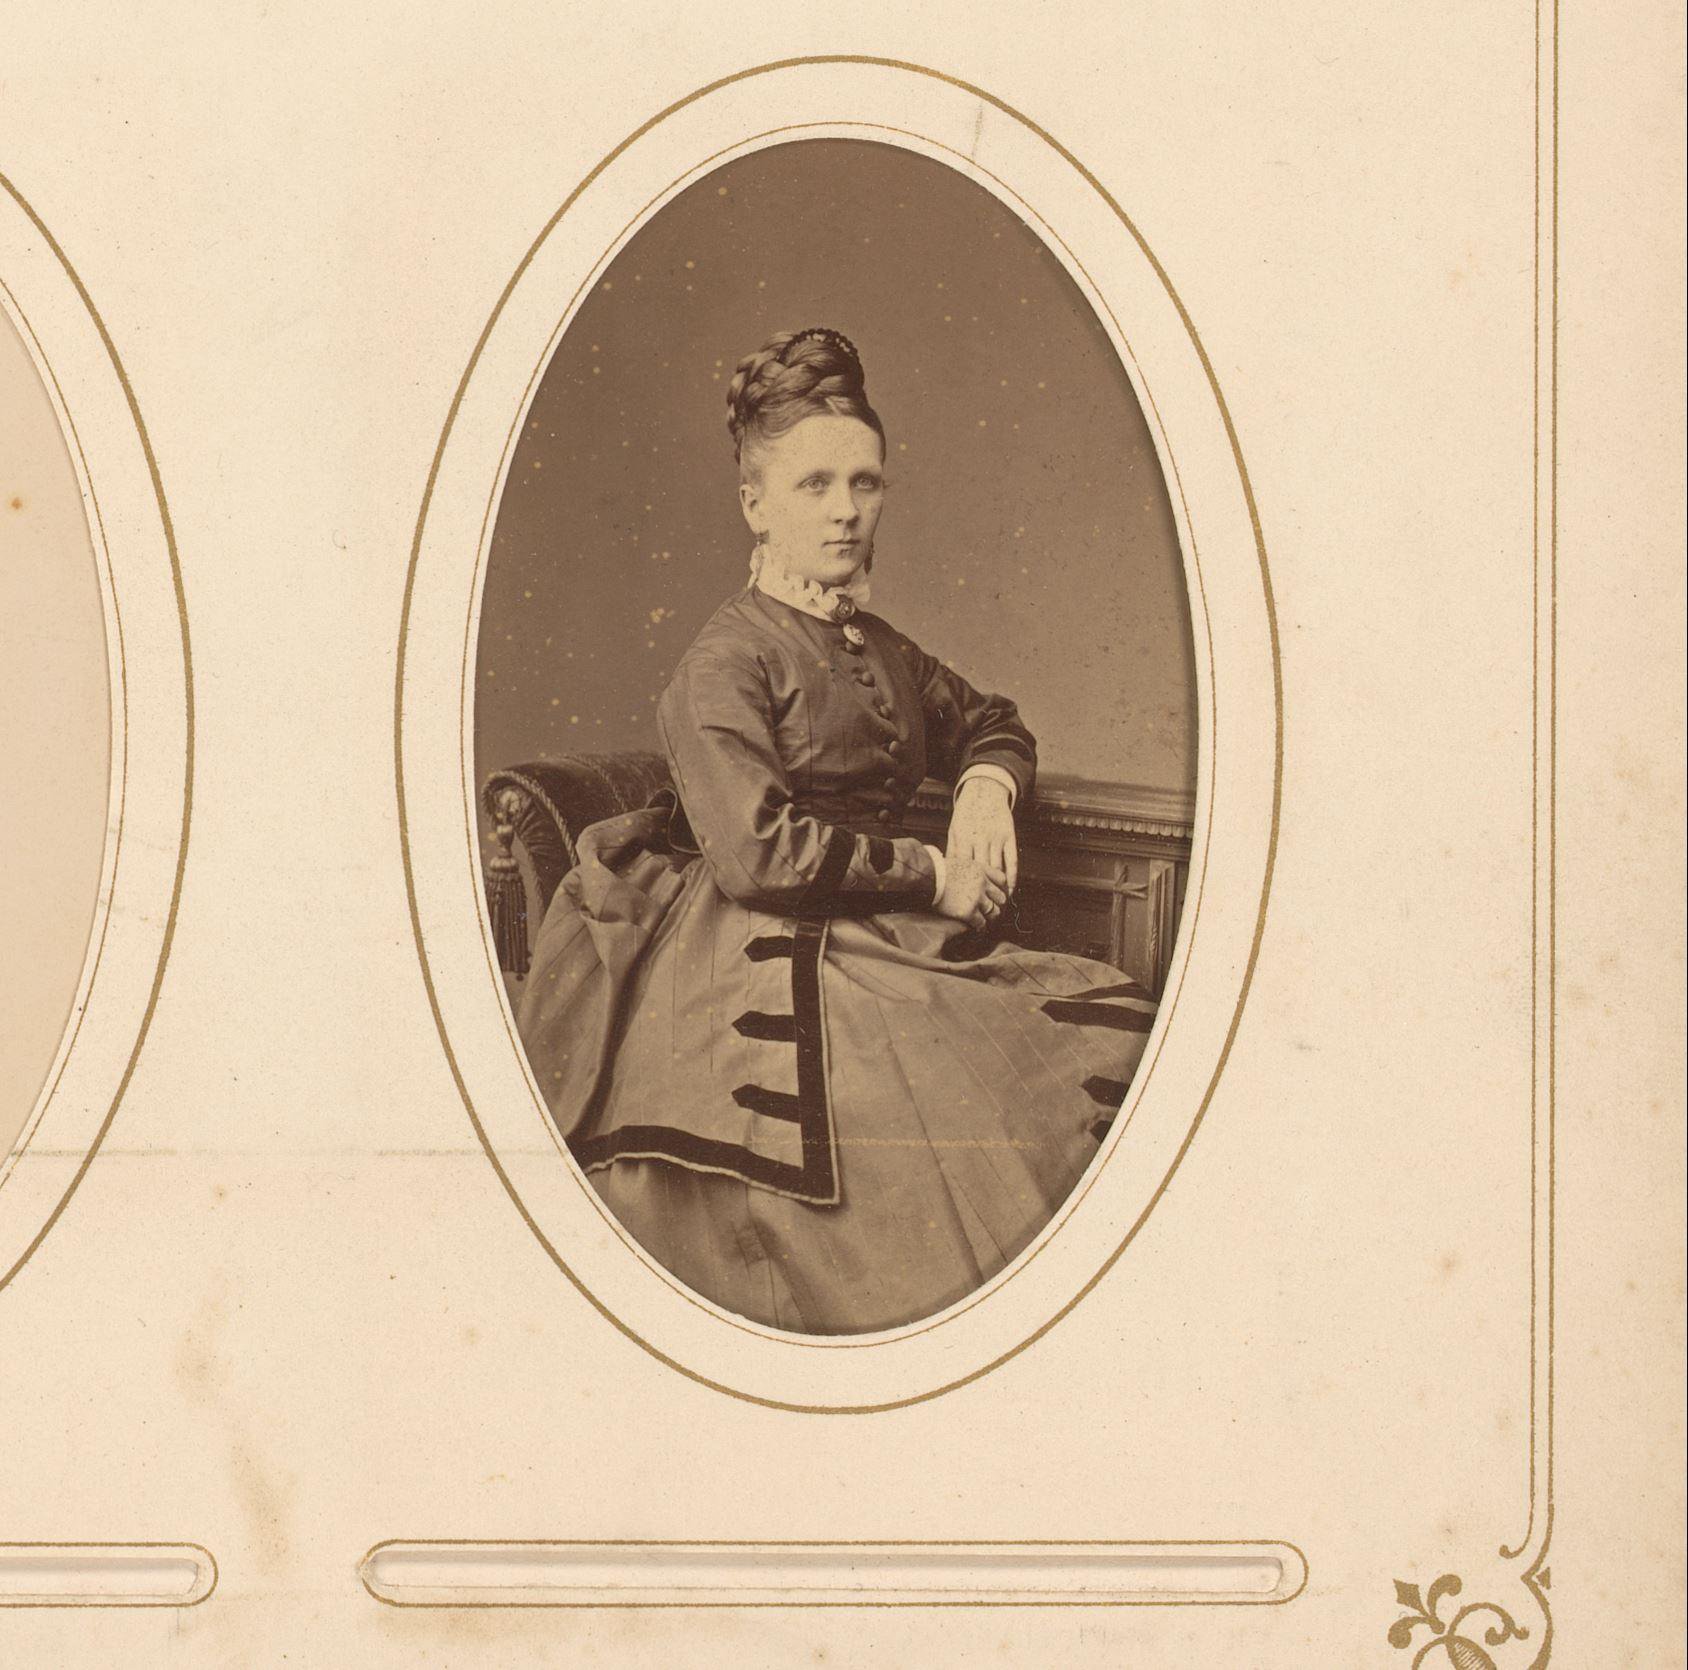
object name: photograph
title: Portret van een zittende vrouw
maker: emil tiedemann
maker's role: fotograaf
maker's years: 1858-1892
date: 1859-1892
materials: cardboard, photographic support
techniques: albumen print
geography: bremen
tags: sitting figure - aa - female human figure, historical persons - bb - woman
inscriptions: inscription: ‘PHOTOGRAPHISCHER SALON/ Emil Tiedemann/ 12 Richtweg 12/ BREMEN.’